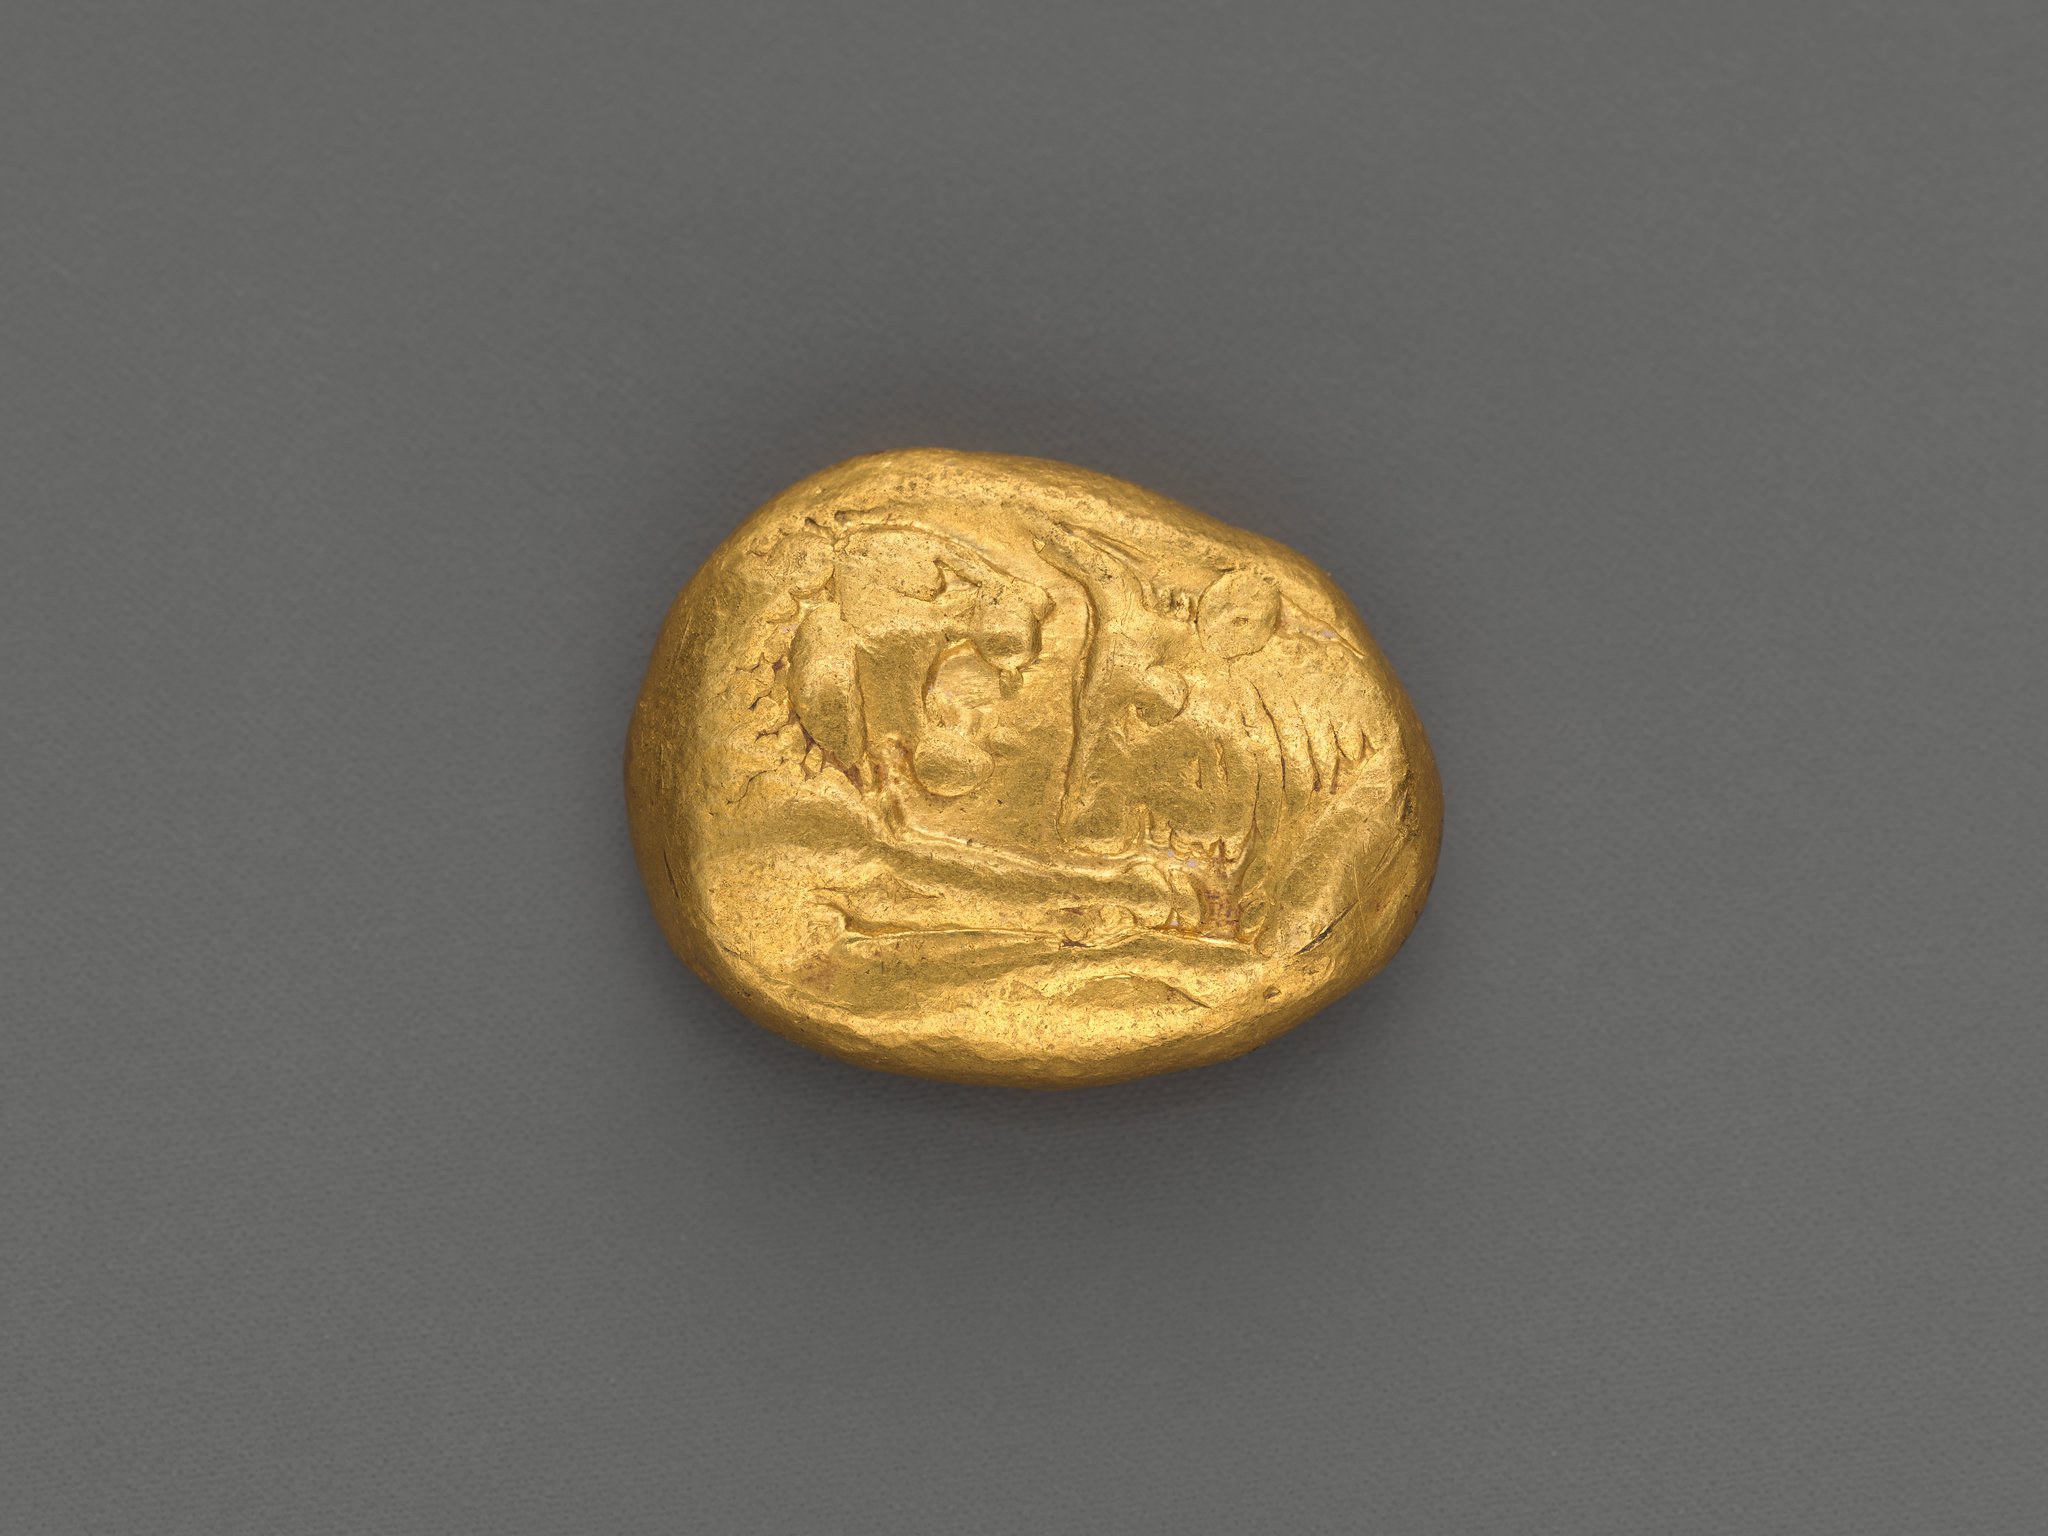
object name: stater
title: Gold stater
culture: lydian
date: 560-546 BCE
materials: gold